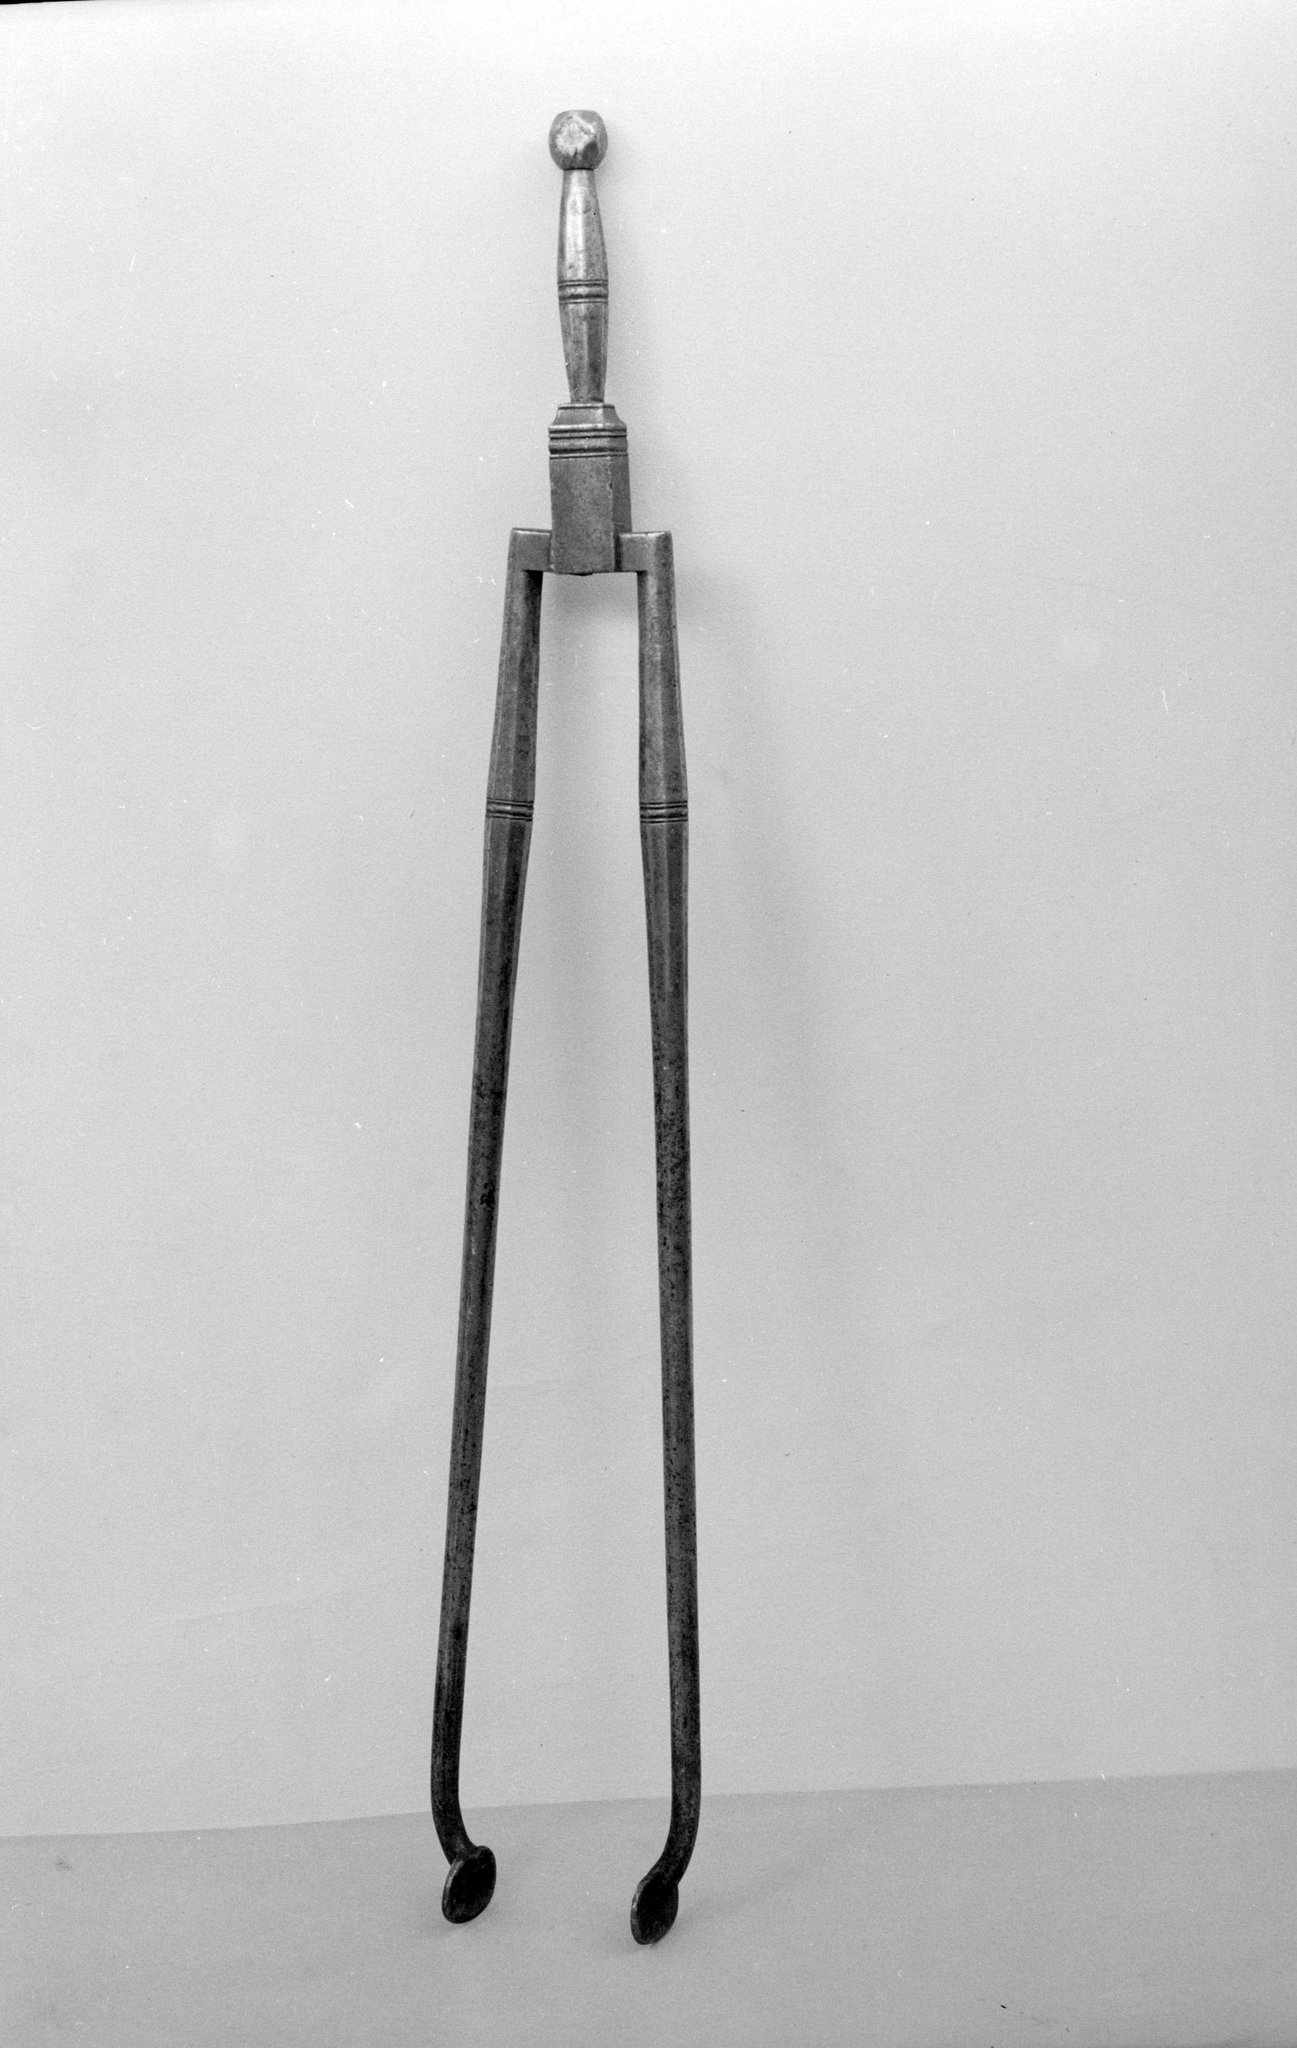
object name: tongs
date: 1701-1800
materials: iron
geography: england